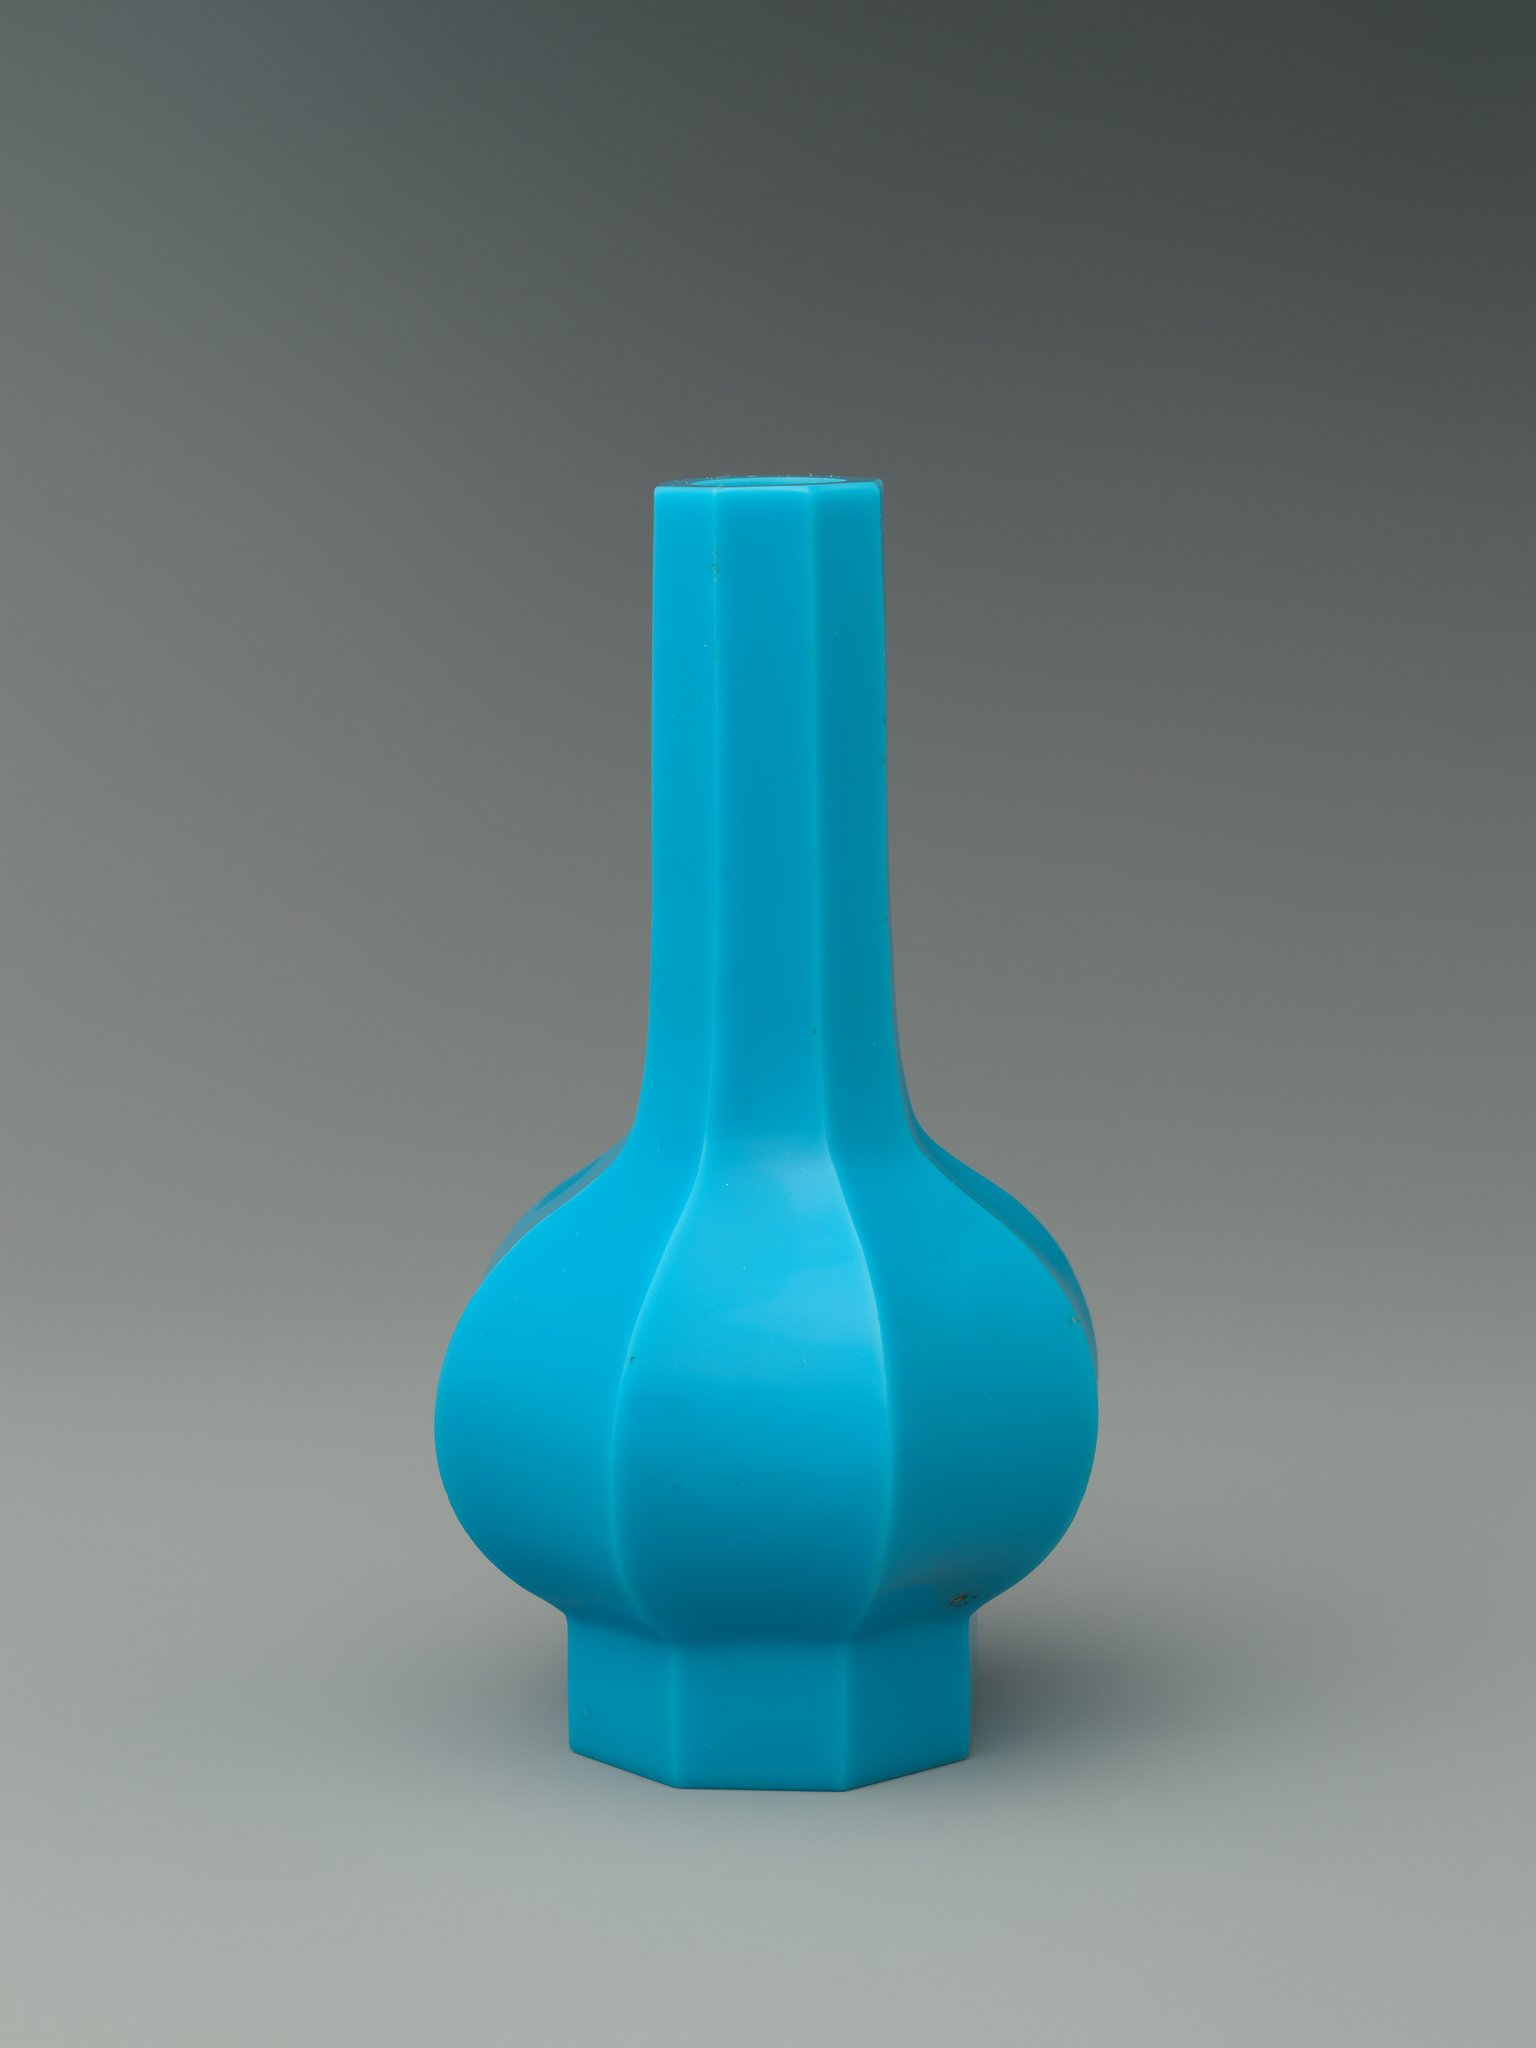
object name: vase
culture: chinese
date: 1734-1766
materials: glass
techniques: glassblowing